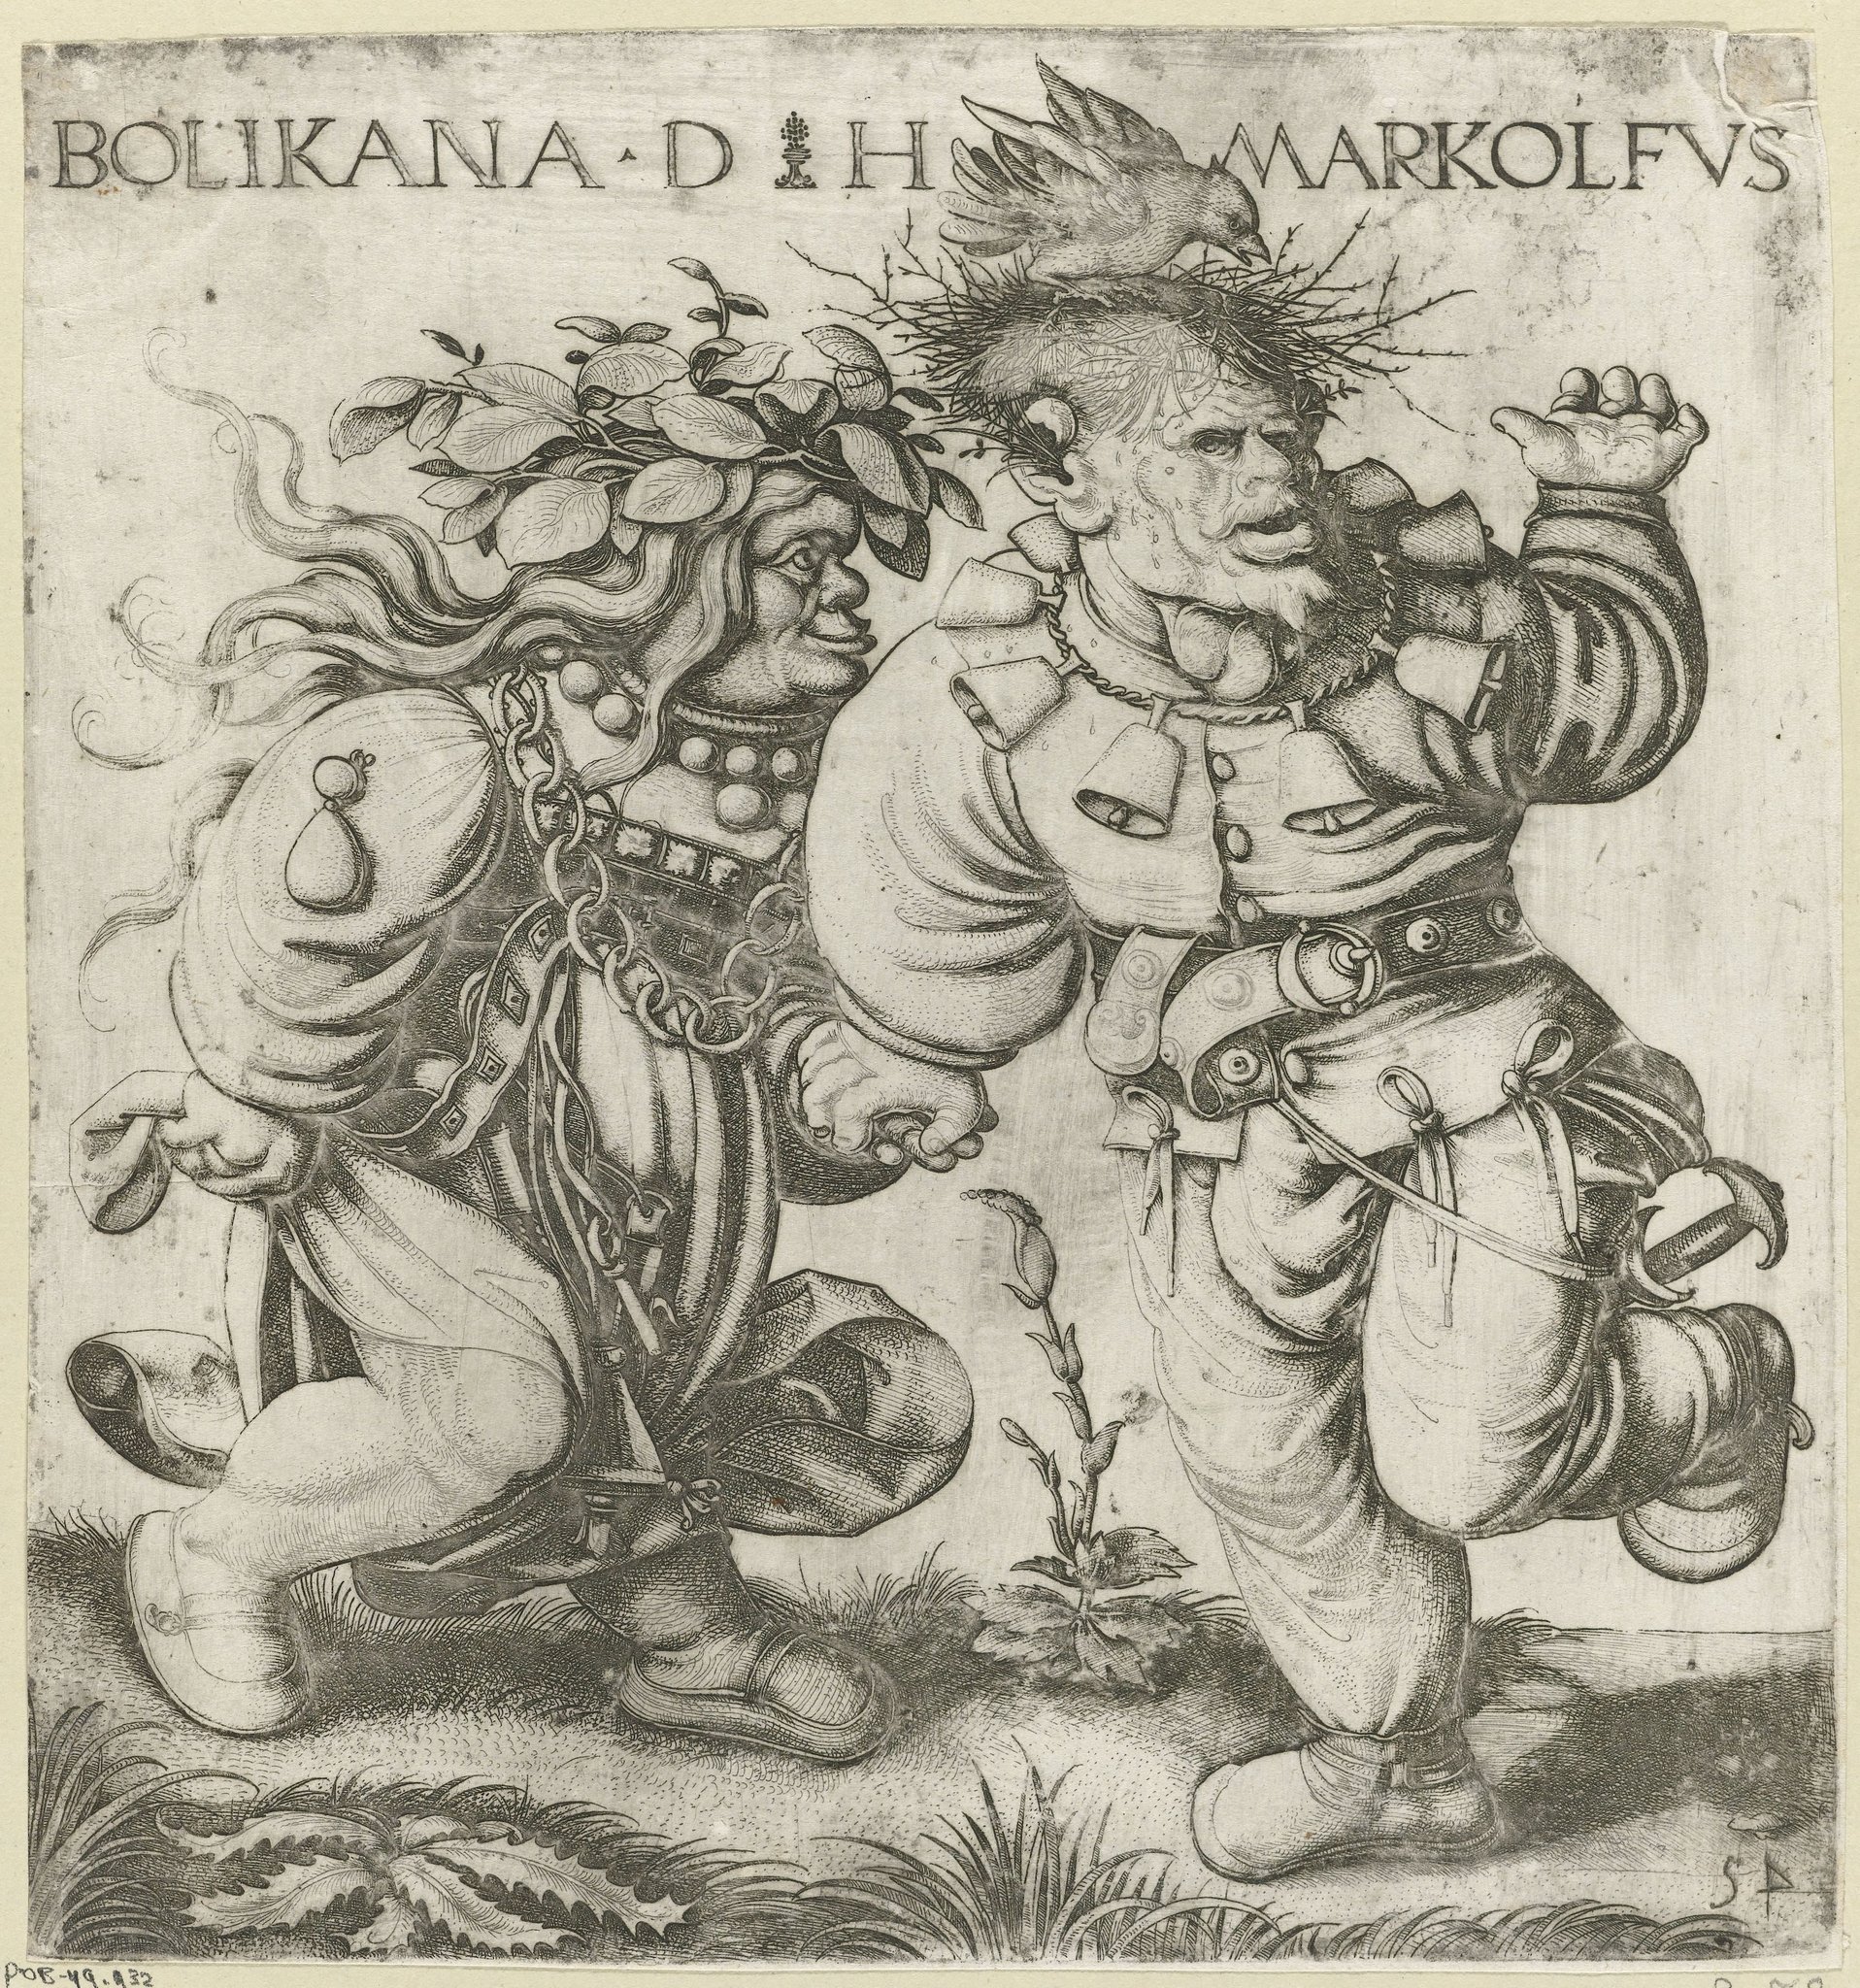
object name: print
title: Bolikana en Markolfus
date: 1521-1536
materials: paper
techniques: etching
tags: folly, foolishness; 'pazzia', 'sciocchezza', 'stoltitia' (ripa) (+ symbolical representation of concept), folk dancing (men and women together), folk costume, regional costume, rhetorician's drama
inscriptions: collector's mark: Lugt 240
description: Voorstelling geïnspireerd op de literaire tekst 'Frag und antwordt Künig Salomonis und Marcolfi' (gepubliceerd vanaf 1487), origineel getiteld 'Dialogus Salomonis et Marcolfi' (gepubliceerd vanaf 1410). David Funck (1642-1709) kocht 230 ijzeren platen van de prentenmakers uit de familie Hopfer aan, nummerde deze (nu bekend als het Funck nummer) en herdrukte de verder onaangetaste platen onder de titel Operae Hopferianae in 1684 in Neurenberg. (Metzger, 2009)